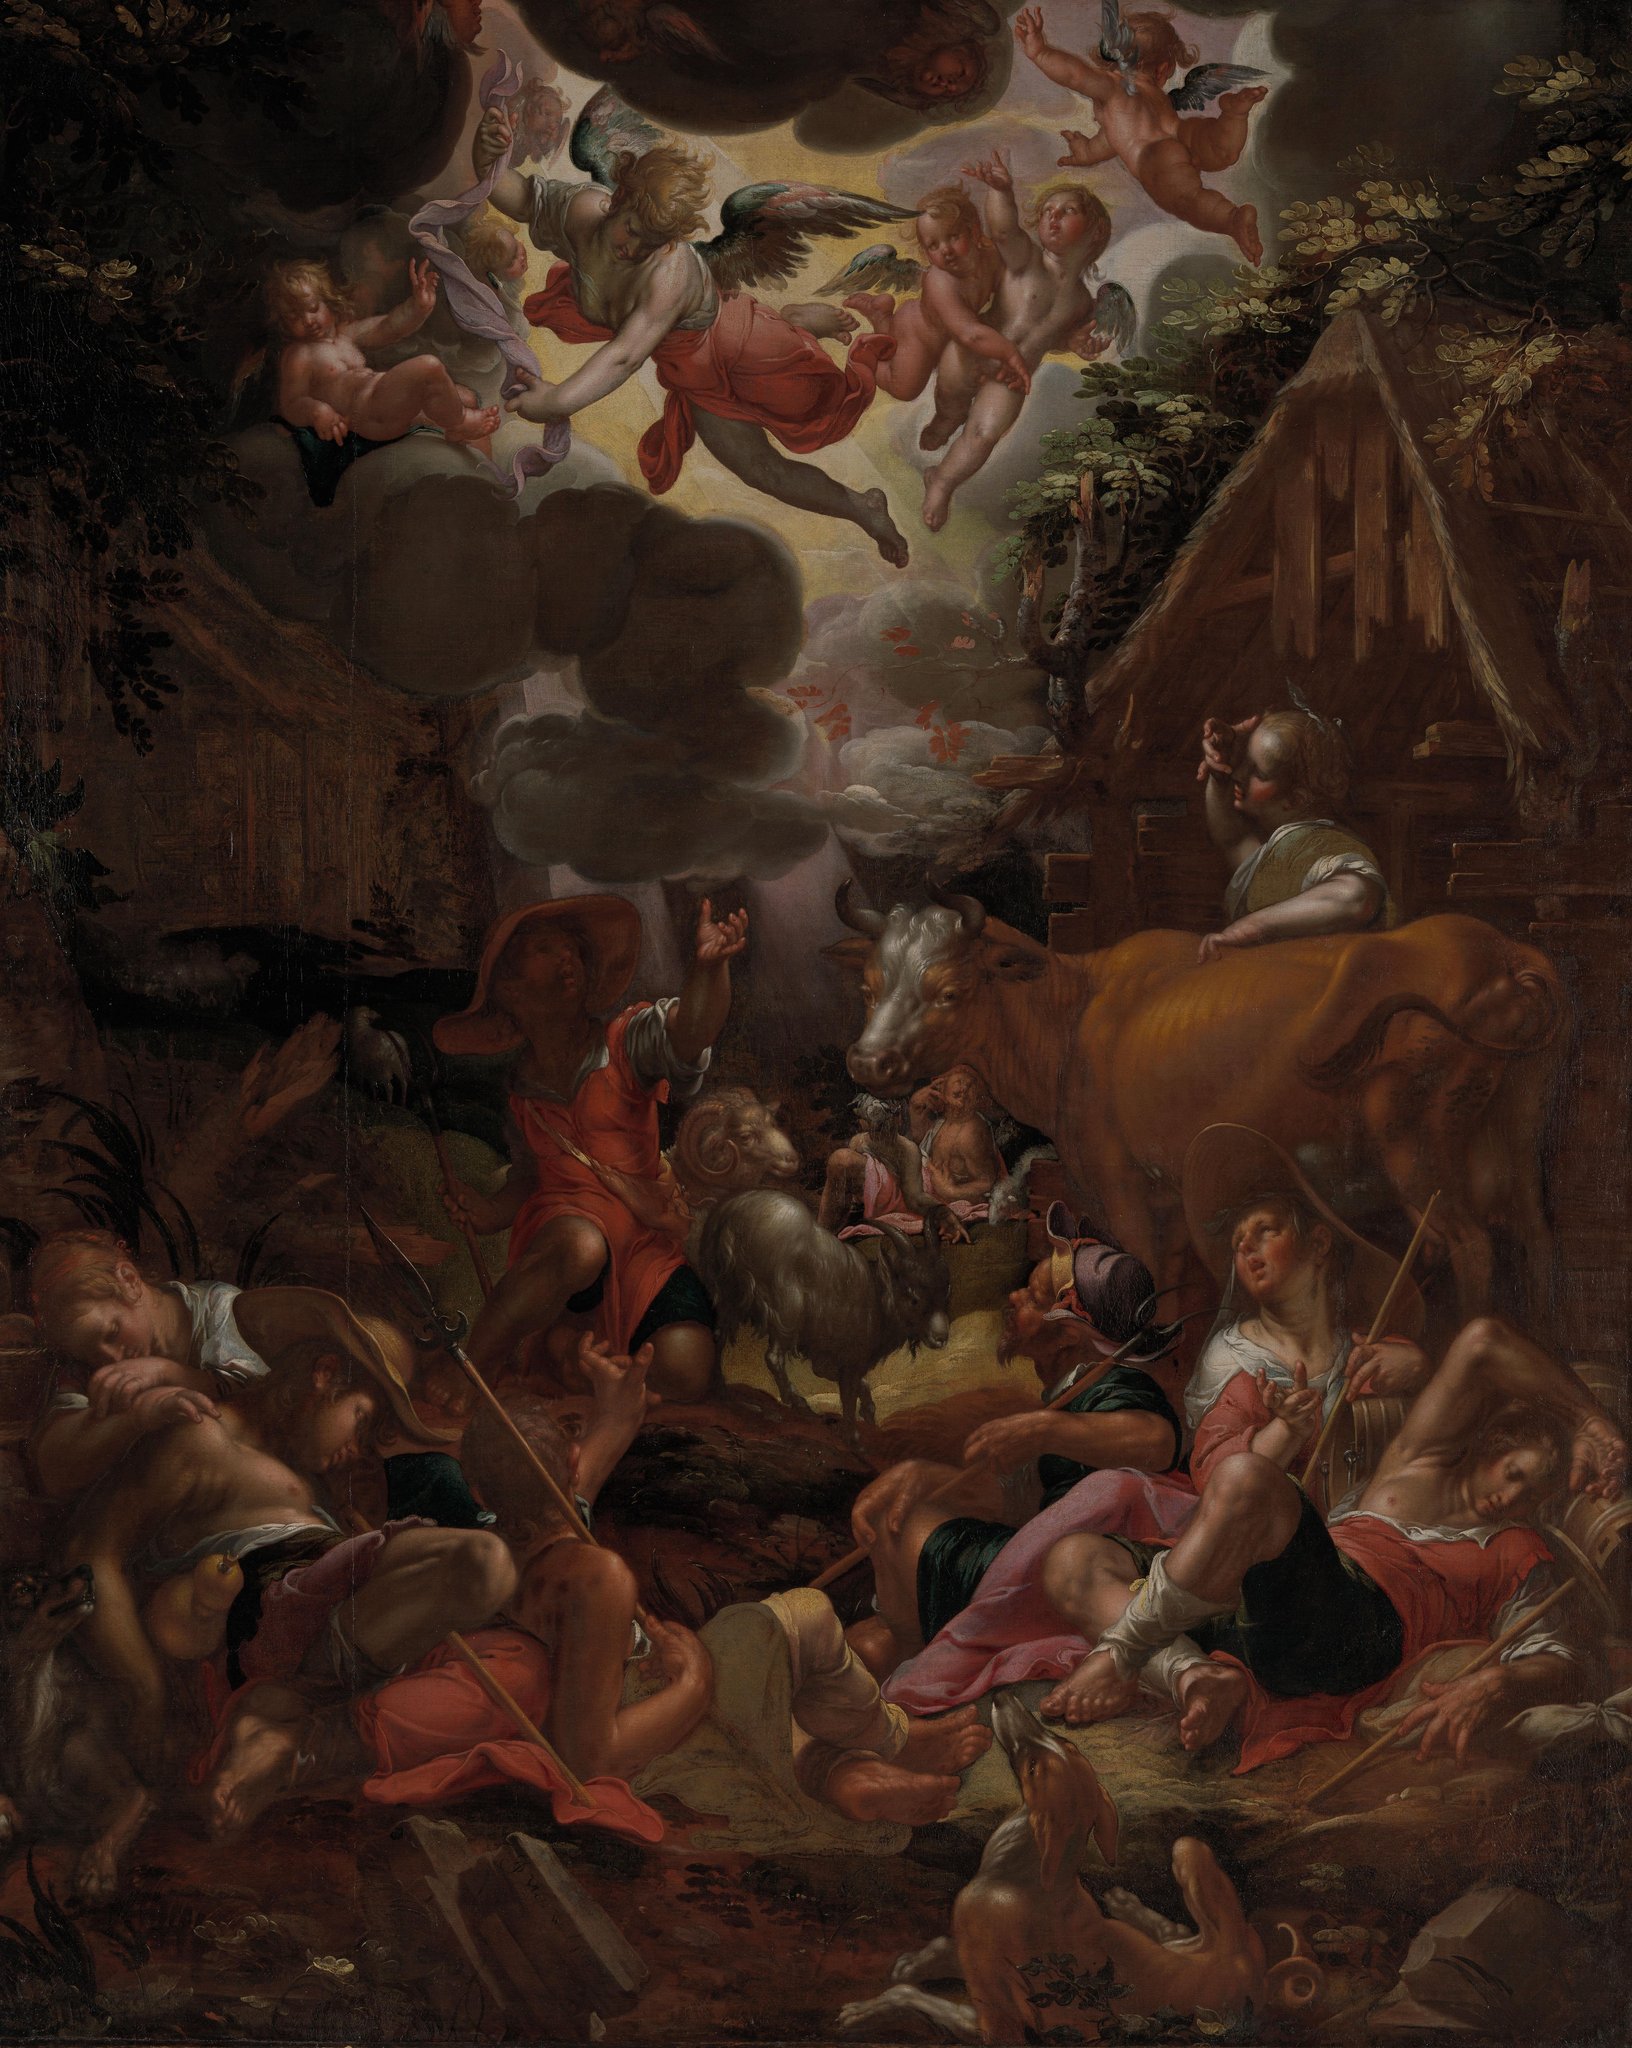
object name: painting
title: Annunciation to the Shepherds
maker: joachim wtewael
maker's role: draughtsman, painter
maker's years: 1566-1638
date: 1595-1603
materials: canvas, oil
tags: annunciation of christ's birth to the shepherds (and/or shepherdesses) at night; a host of singing angels in the air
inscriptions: signature: ‘Jo. Wtenwael fe’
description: In keeping with the biblical account, the night sky bursts open and the ‘splendour of the Lord' shines on the shepherds, some of whom are still asleep. An angel announces the birth of Jesus. The supernatural light is so bright that some of the figures have to shield their eyes. The contorted limbs and poses are typical of Mannerism, the style in which Wtewael excelled.